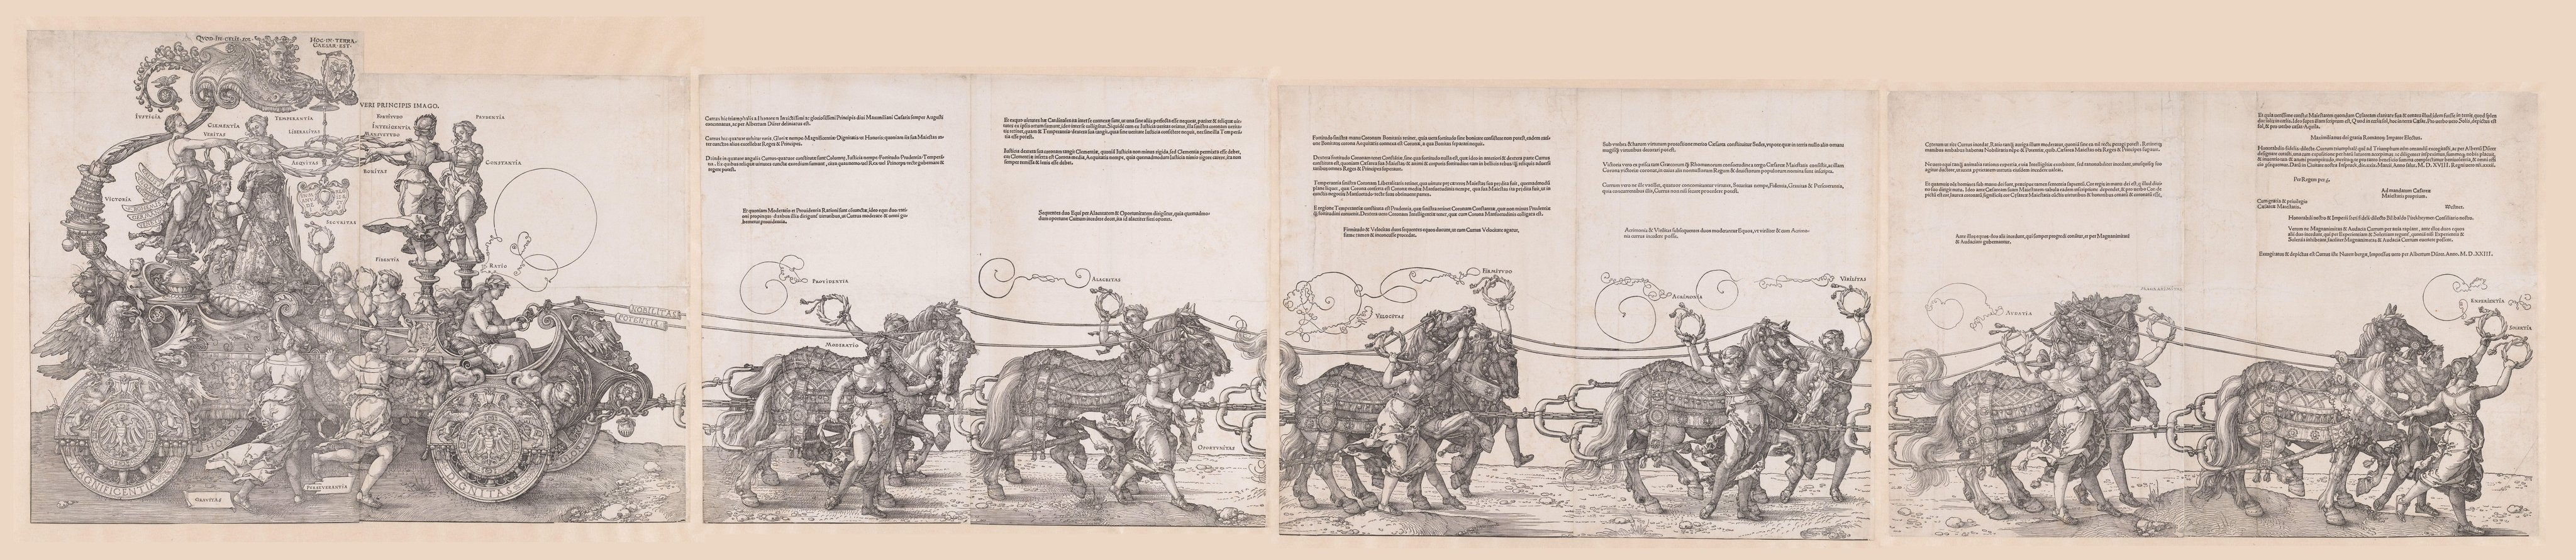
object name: print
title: Triomfwagen van keizer Maximiliaan I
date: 1523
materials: paper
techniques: woodcut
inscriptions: collector's mark: Lugt 240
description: Dit object is omwille van een betere presentatie virtueel samengevoegd, maar bestaat uit fysieke onderdelen.